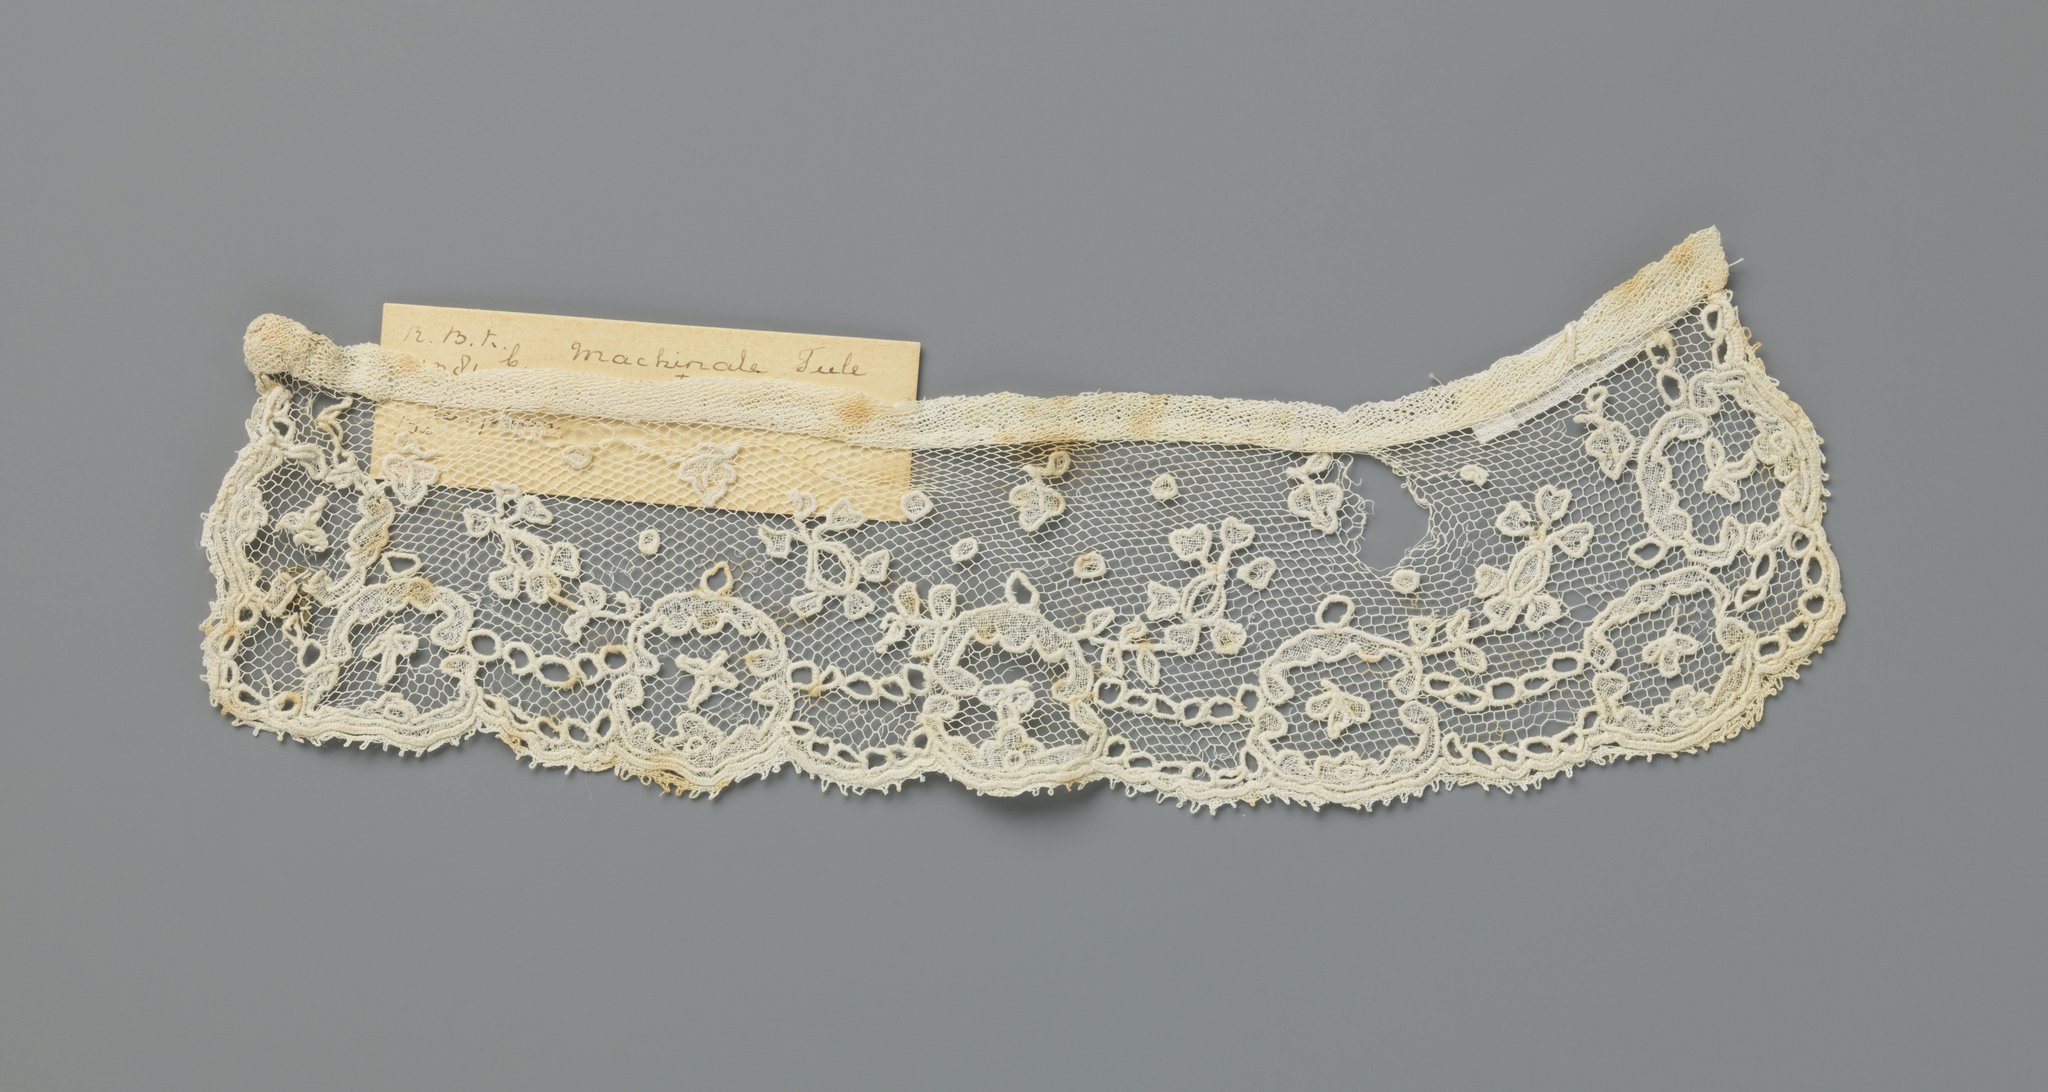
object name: cuff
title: Manchet van applicatiekant met ronde cartouches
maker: Anonymous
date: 1850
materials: textile, cotton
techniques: lace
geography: netherlands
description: Manchet van naturelkleurige applicatiekant: batist geappliceerd op machinale tule. Het zich herhalende patroon bestaat langs de onderrand uit twee c-voluten die een min of meer rond cartouche vormen. In elk cartouche staat een driebladig motiefje. De cartouches zijn onderling met elkaar verbonden door één paar slingertjes van opengewerkte cirkeltjes. Hierboven staat een strooipatroon van moesjes en kleine bloempjes of blaadjes. De bovenzijde is afgewerkt met een zoompje. De schulpenrand aan onderzijde loopt door in beide korte zijden is afgewerkt met picots. De manchet kan worden gesloten door middel van twee haakjes.